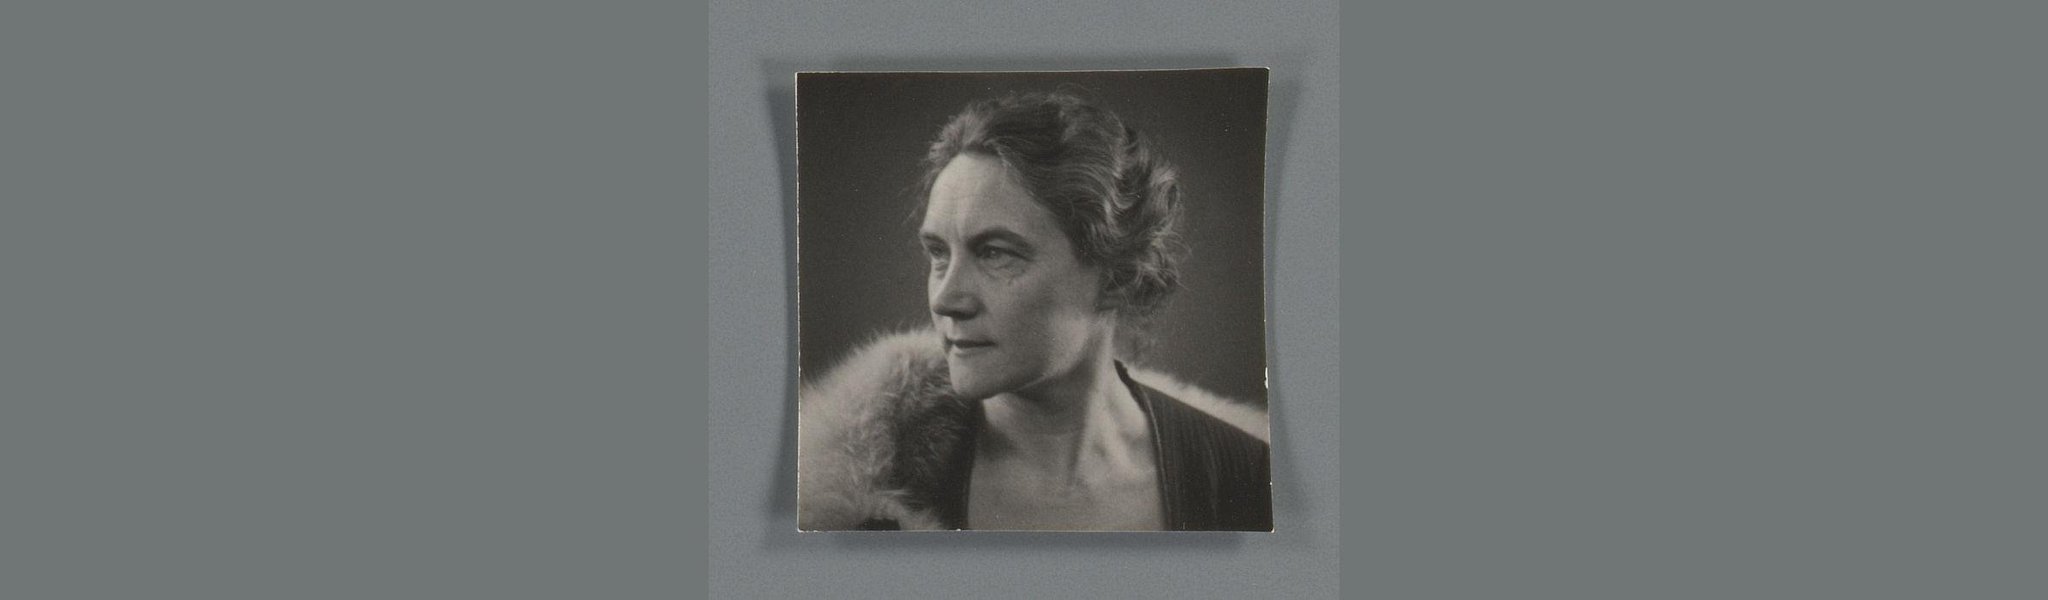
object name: snapshot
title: Portret van Johanna (Hans) de Jong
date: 1903-1940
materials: paper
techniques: gelatin silver print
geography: the hague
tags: leiden, johanna petronella lambertina stokhuyzen-de jong (hans), historical persons - bb - woman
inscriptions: number: ‘17’